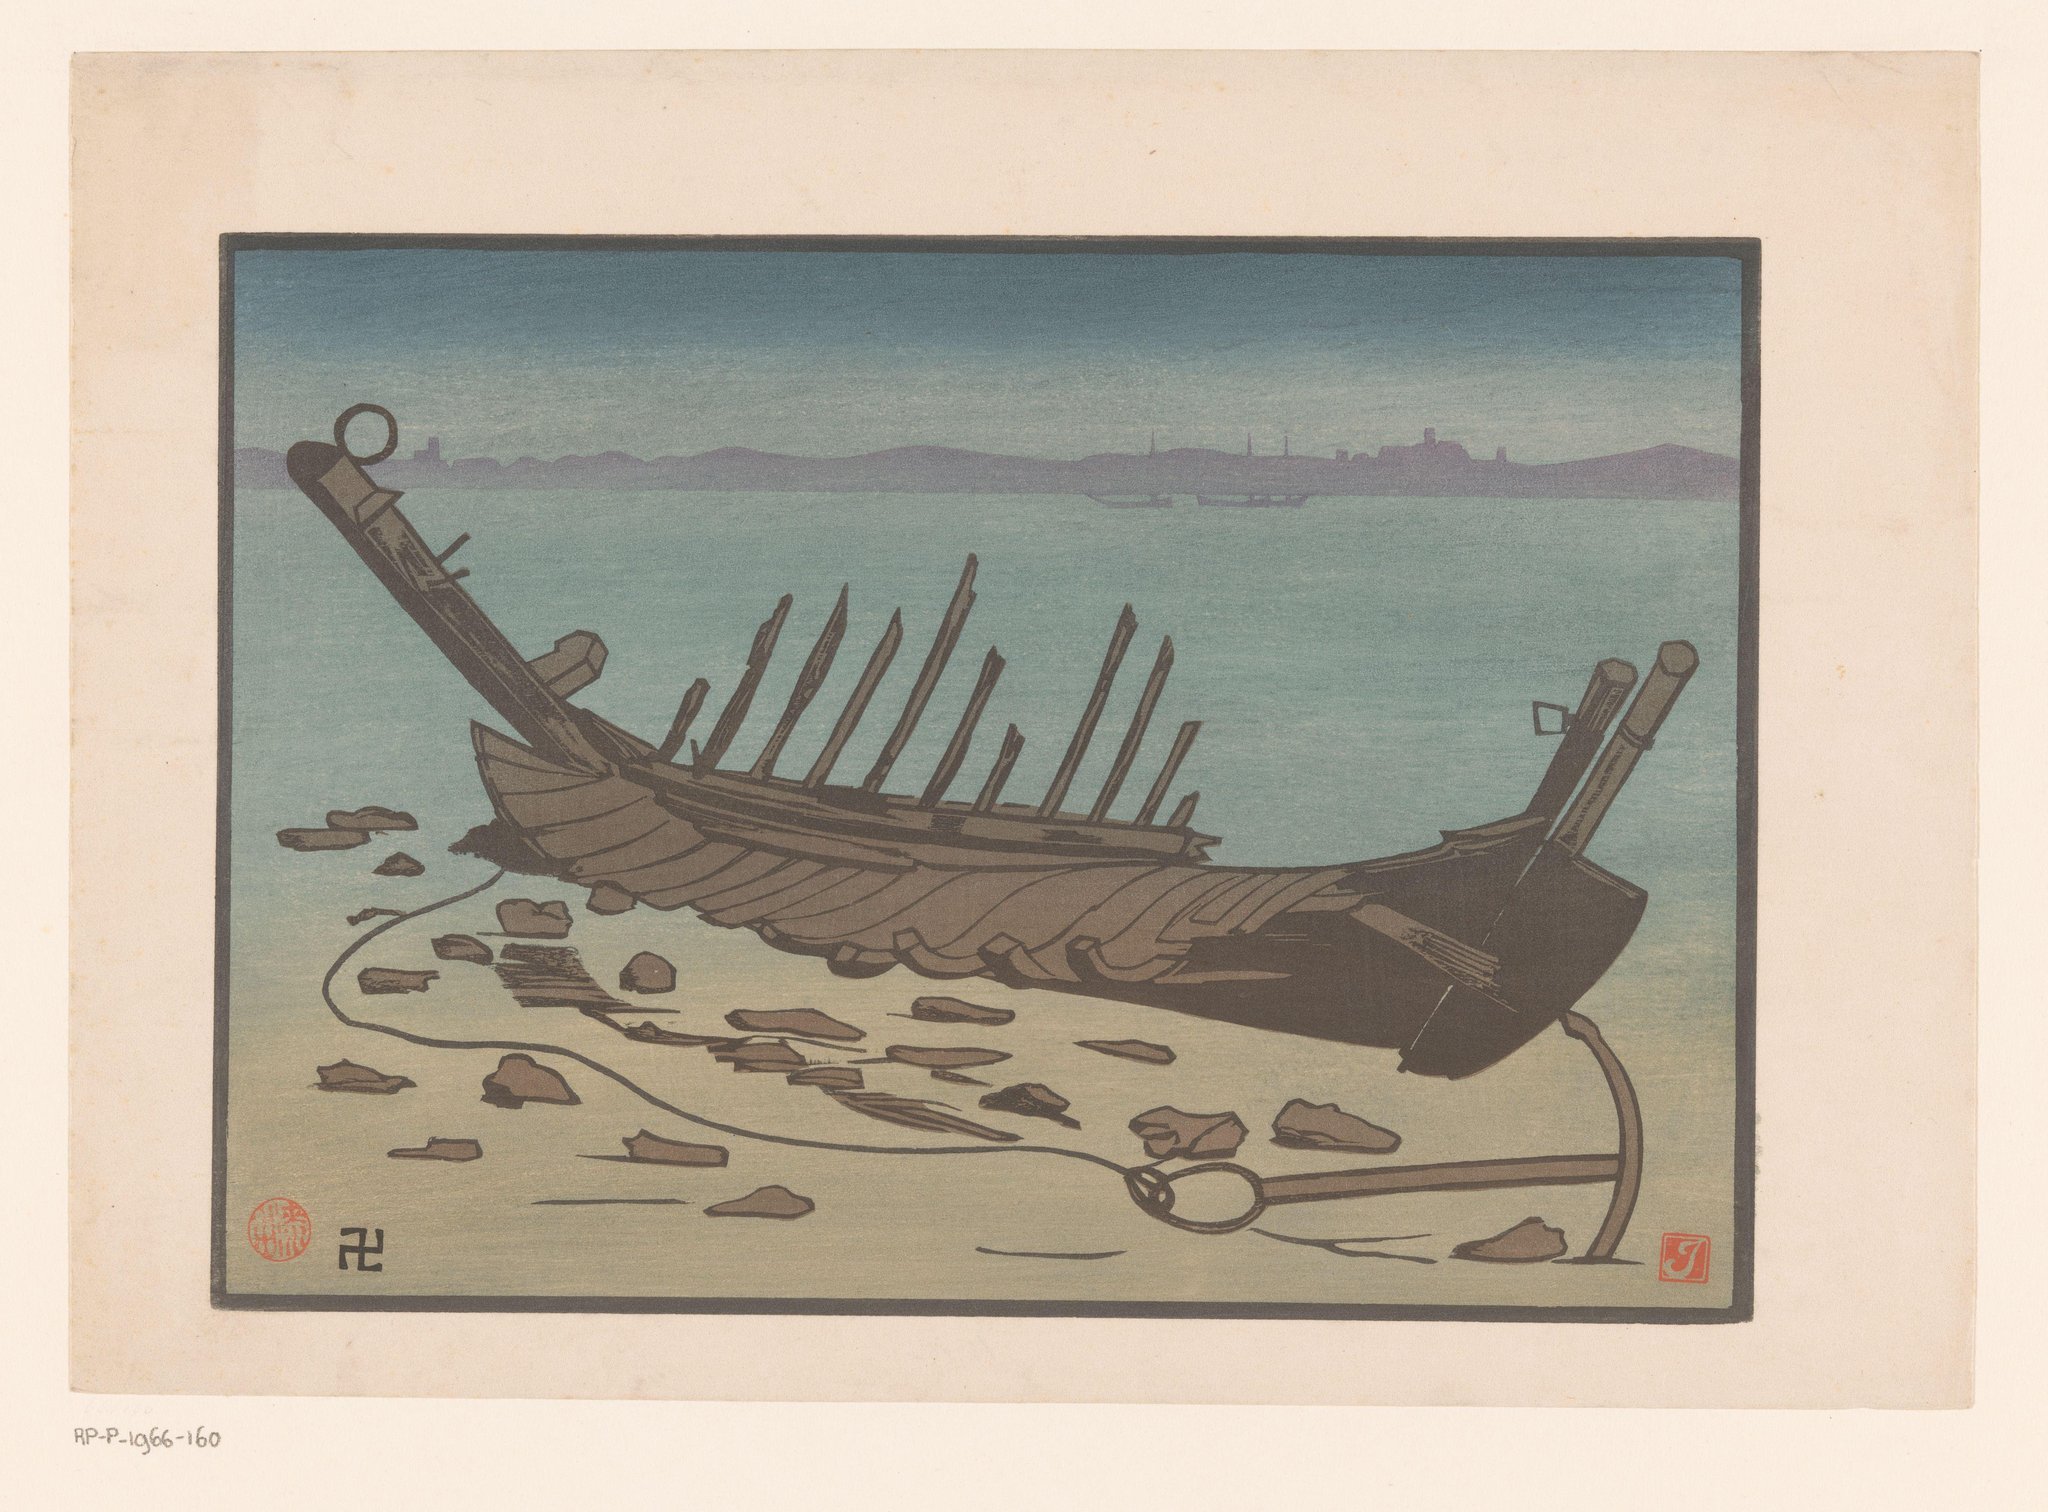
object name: print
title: Wrak van roeiboot op strand in Cancale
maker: prosper-alphonse isaac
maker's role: draughtsman, print maker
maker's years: 1858-1924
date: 1912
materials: paper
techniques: woodcut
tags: shipwreck, wreck ashore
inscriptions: collector's mark: Lugt 2228, stamp, stamp: Lugt 4990